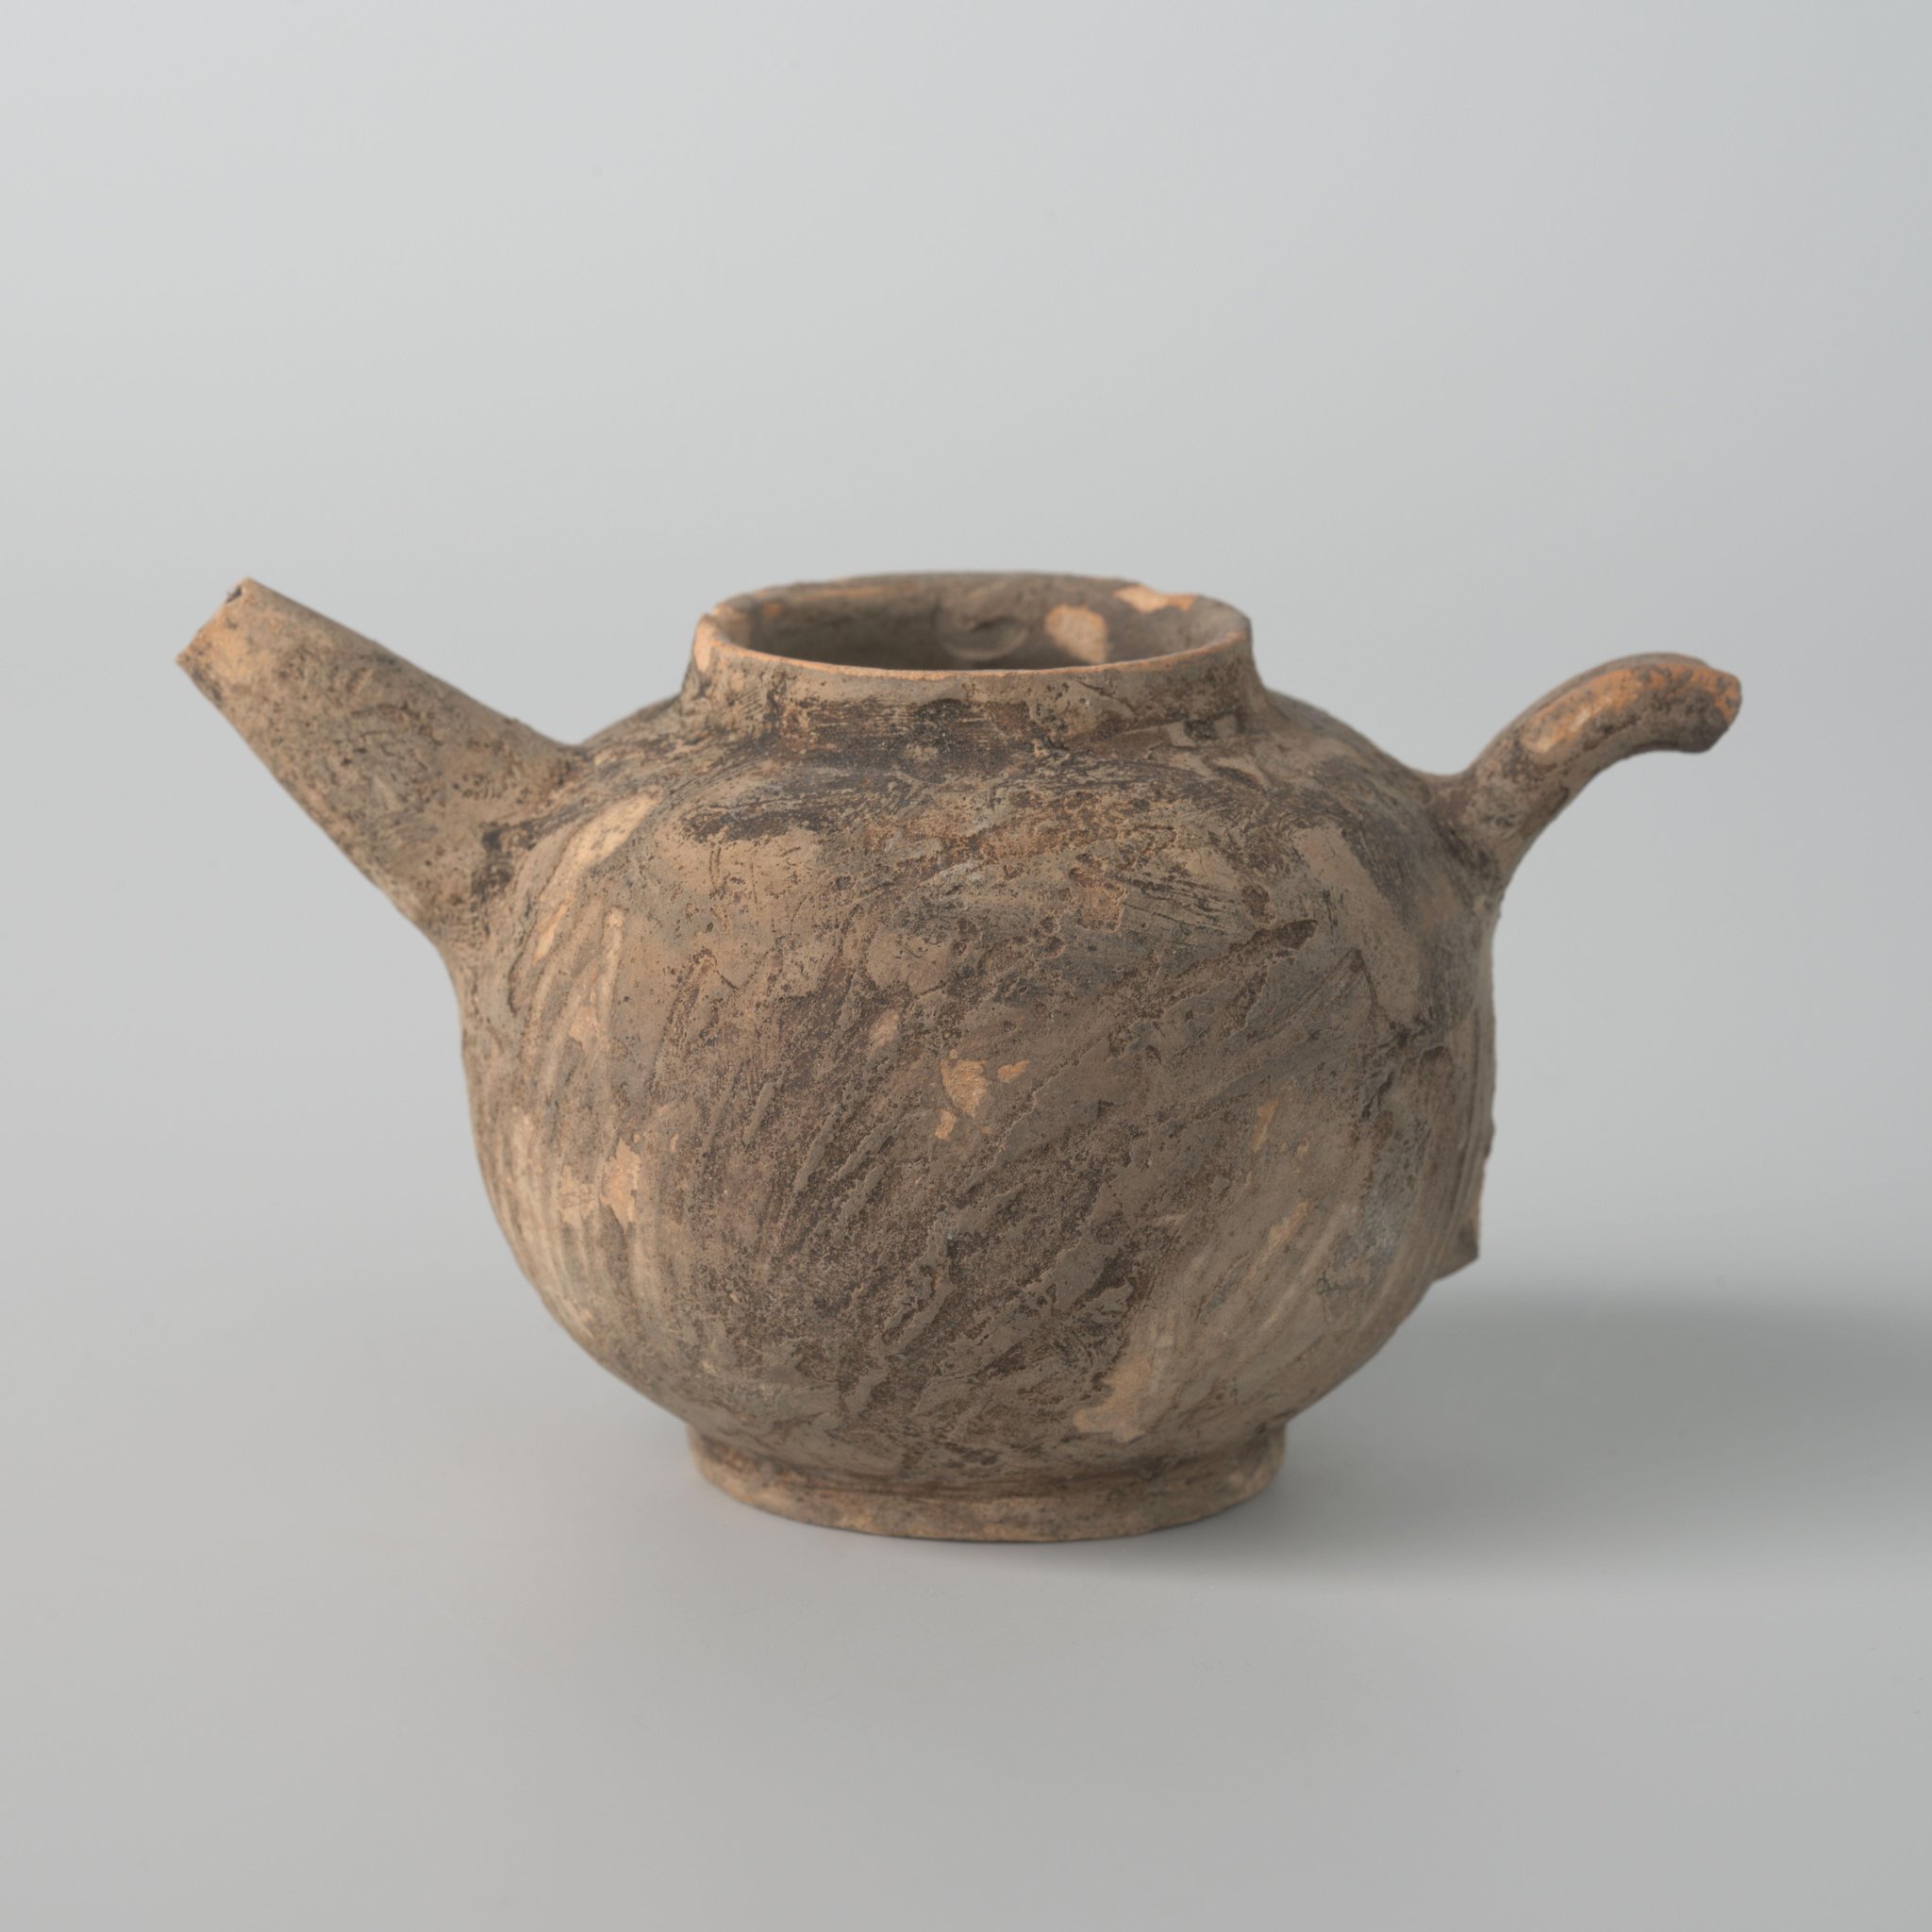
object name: teapot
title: Theepot van ongeglazuurd aardewerk (De Caluwe bakafval)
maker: jacobus de caluwe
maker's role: plateelbakkerij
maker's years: -1730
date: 1700-1725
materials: earthenware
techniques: firing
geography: delft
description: Toegeschreven aan Jacobus de Caluwe, omdat dit voorwerp samen met gemerkte stukken (‘Jacobus De Caluwe’ en rennend hert) gevonden is op de plaats waar zich De Caluwes tweede werkplaats bevond. Er is een duidelijke stilistische overeenkomst tussen de gemerkte en niet gemerkte voorwerpen uit deze archeologische vondst.